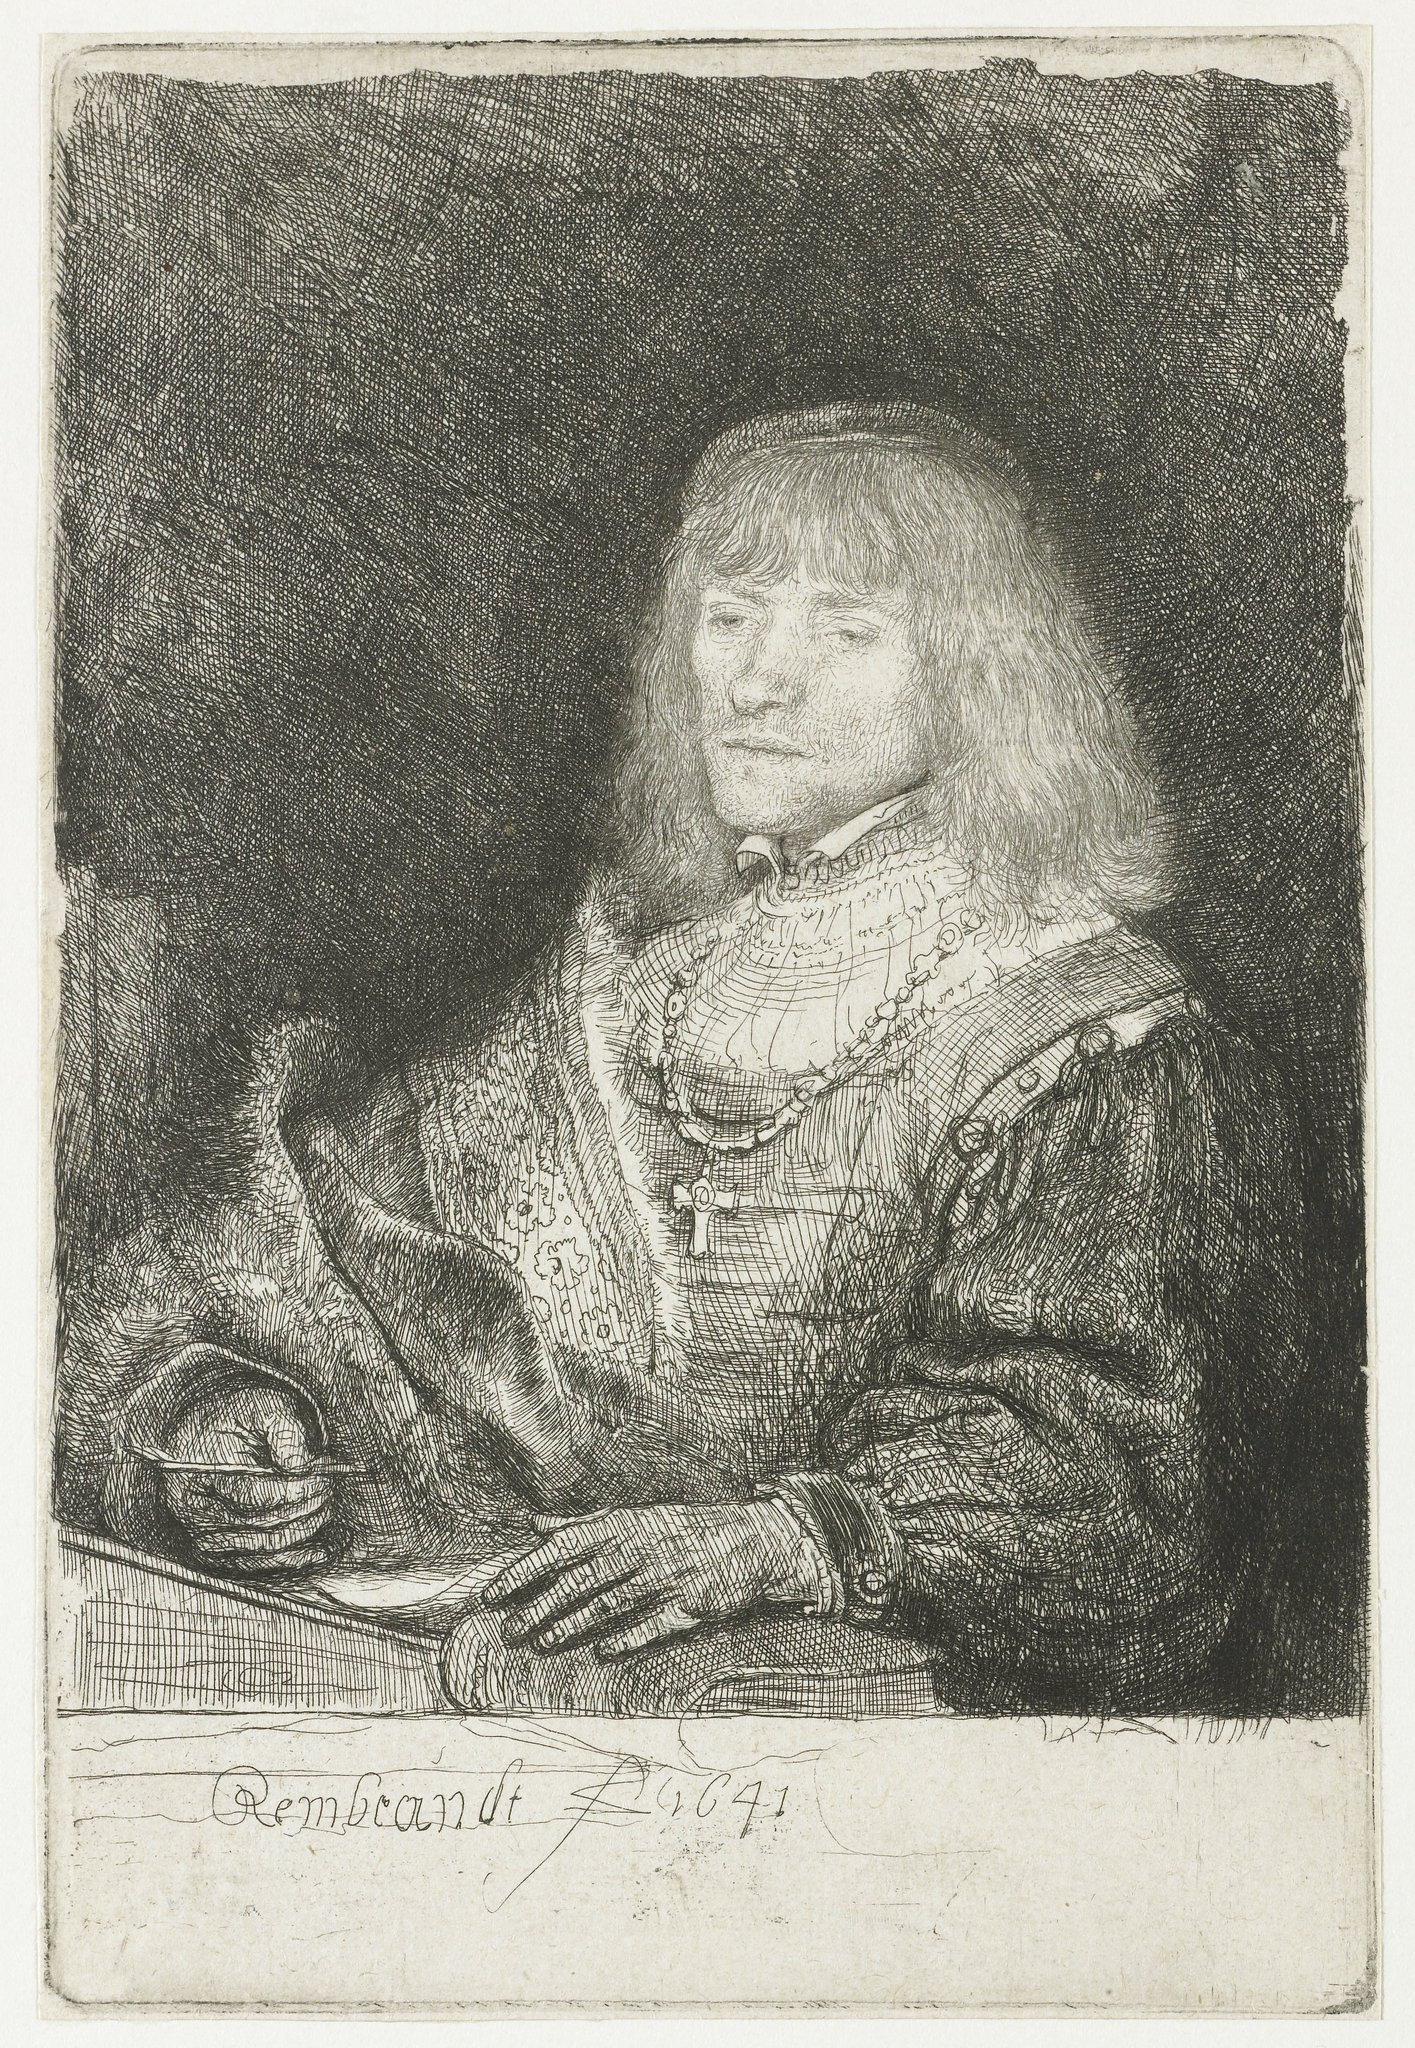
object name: print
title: Man at a desk wearing a cross and chain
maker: rembrandt van rijn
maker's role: draughtsman, painter, print maker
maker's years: 1606-1669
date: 1641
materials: paper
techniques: drypoint, etching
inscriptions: collector's mark: Lugt 240, signature and date: ‘Rembrandt f 1641’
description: Standing before a writing desk, this man reflects on what he wishes to pen. He wears a sumptuous 16th-century costume with a costly cloak draped over his right shoulder. His face is executed with great refinement; however his identity is unknown. Rembrandt often portrayed his clients dressed à l’antique.